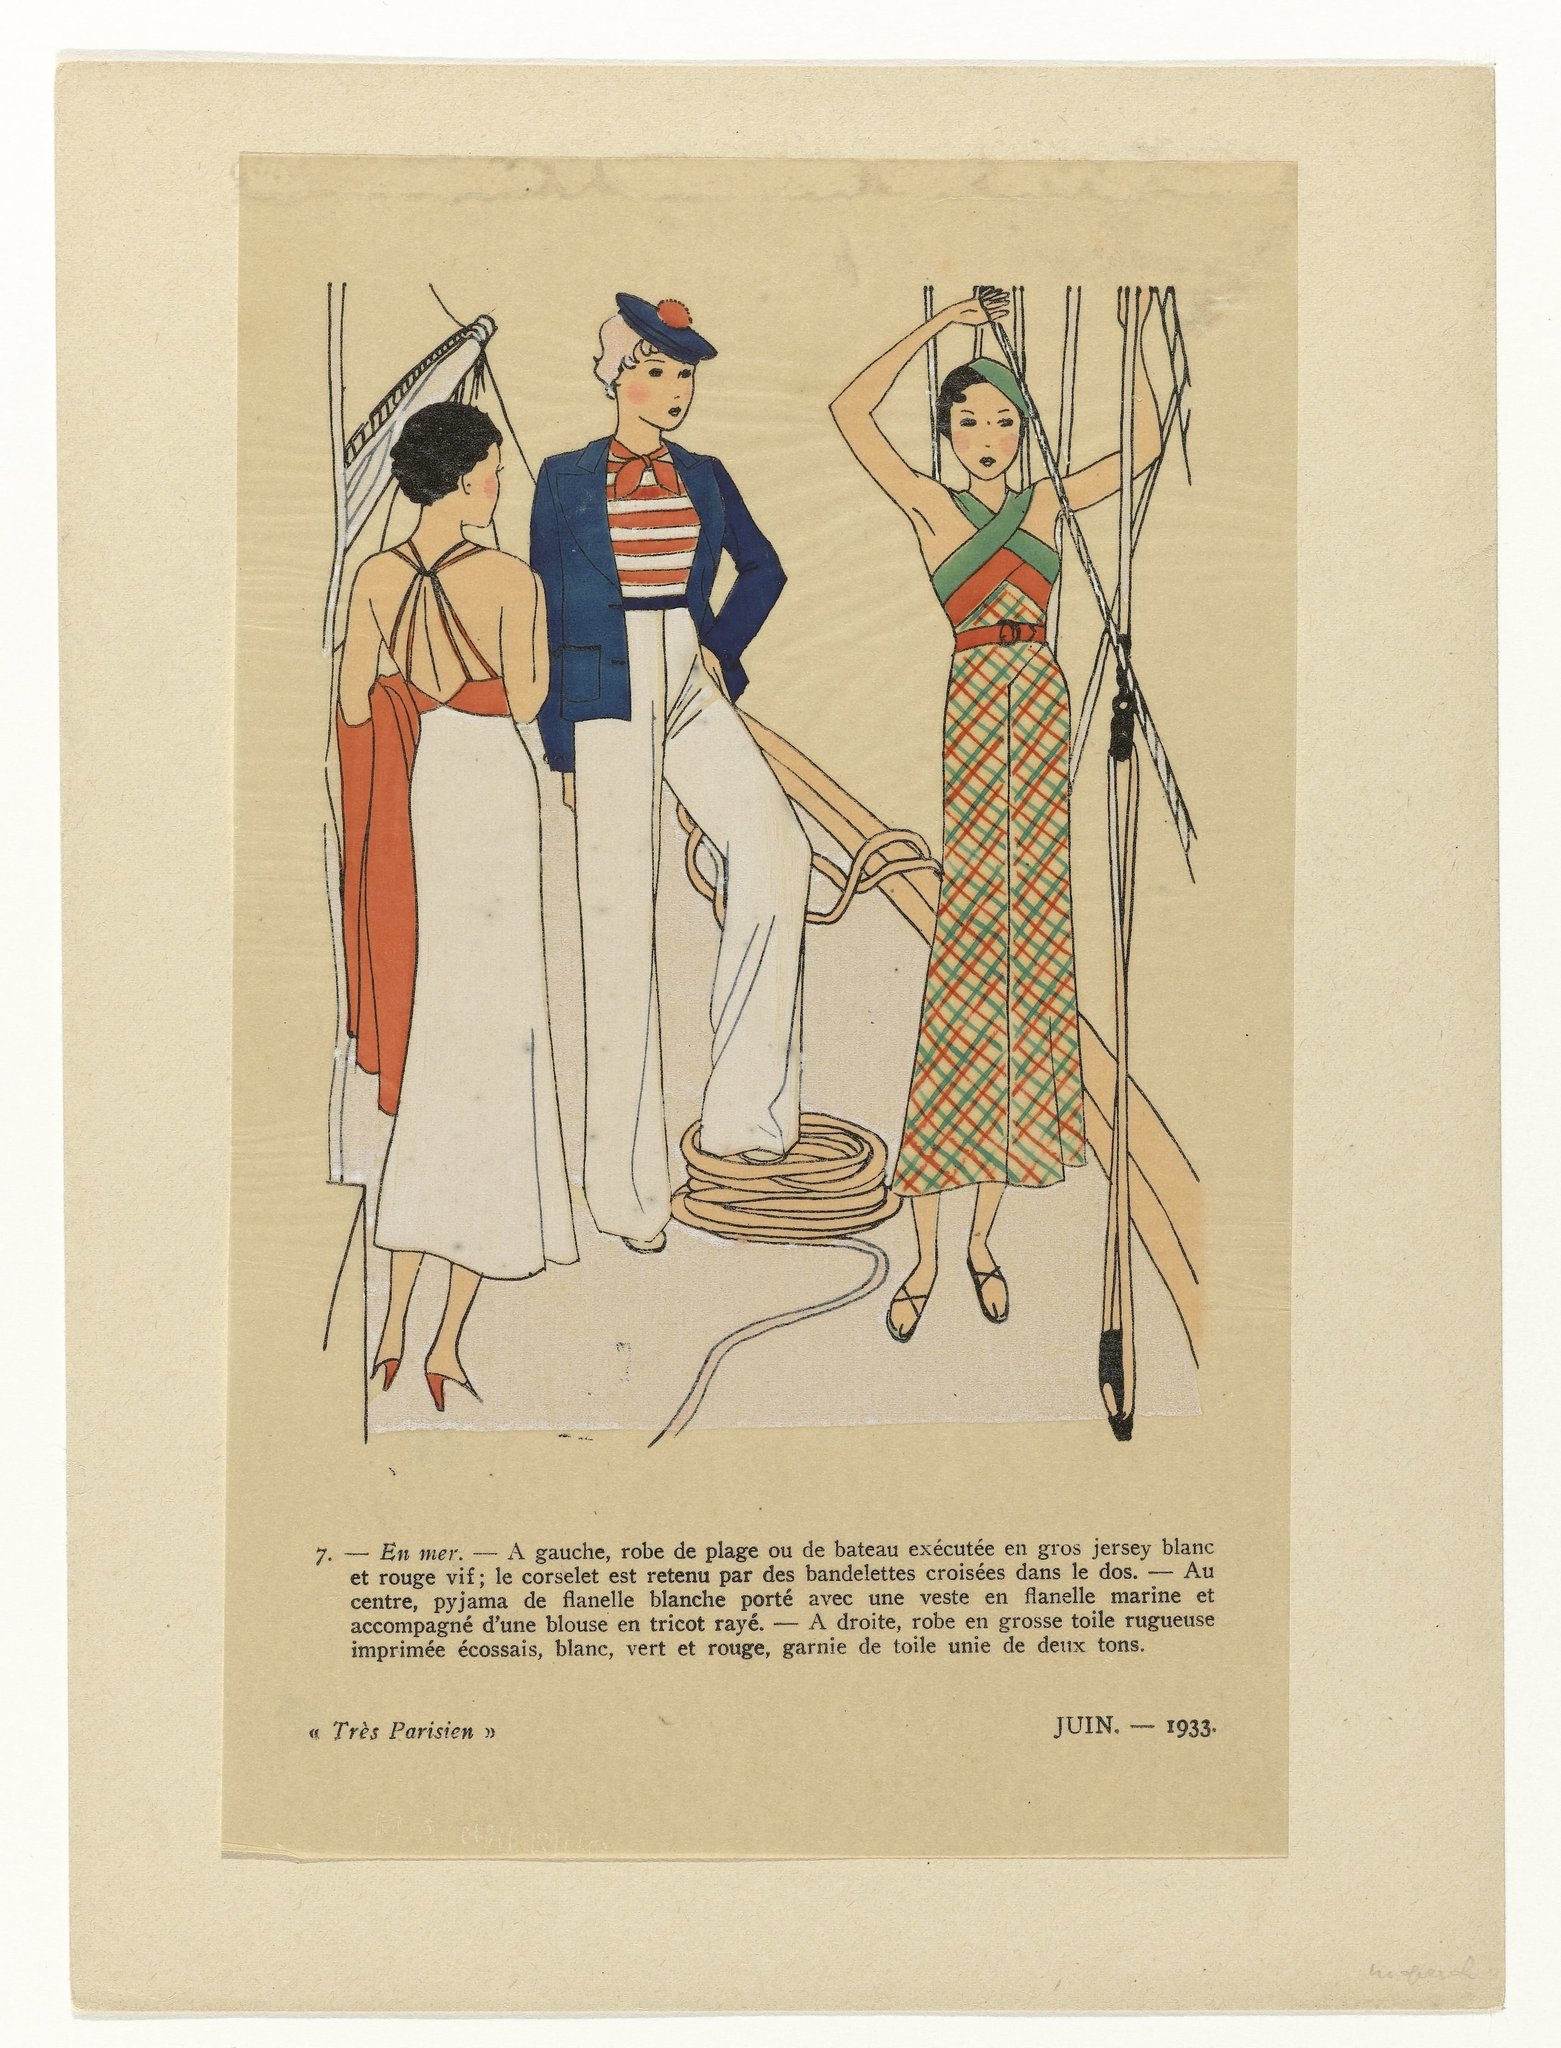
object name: fashion print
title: Très Parisien, Juin 1933, No. 7 : En mer.- A gauche, robe de plag (...)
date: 1933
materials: paper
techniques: hand coloring, letterpress printing, lithography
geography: paris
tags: border, ribbon, braid (+ women's clothes), clothing for the upper part of the body: blouse (+ women's clothes), head-gear: beret (+ women's clothes), dress, gown (seaside dress) (+ women's clothes), coat (+ women's clothes), fashion plates, crew and passengers ~ ship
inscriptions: caption: ‘7. - En mer - A gauche, robe de plage ou de bateau exécutée en gros jersey blanc et rouge vif; le corselet est retenu par des bandelettes croisées dans le dos.- Au centre, pyjama de flanelle blanche porté avec une veste en flanelle marine et accompagné d'une blouse en tricot rayé. - A droite, robe en grosse toile rugueuse imprimée écossais, blanc, vert et rouge, garnie de toile unie de deux tons.’, title: ‘Très Parisien / JUIN. - 1933.’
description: Links een strandjurk van jersey, met kruisbanden op de rug. In het midden een strandpyjama van witte flanel, met marineblauw vest en een gestreepte blouse van tricot. Rechts een japon van grof linnen bedrukt met Schotse ruit. Prent uit het modetijdschrift Très Parisien (1920-1936).